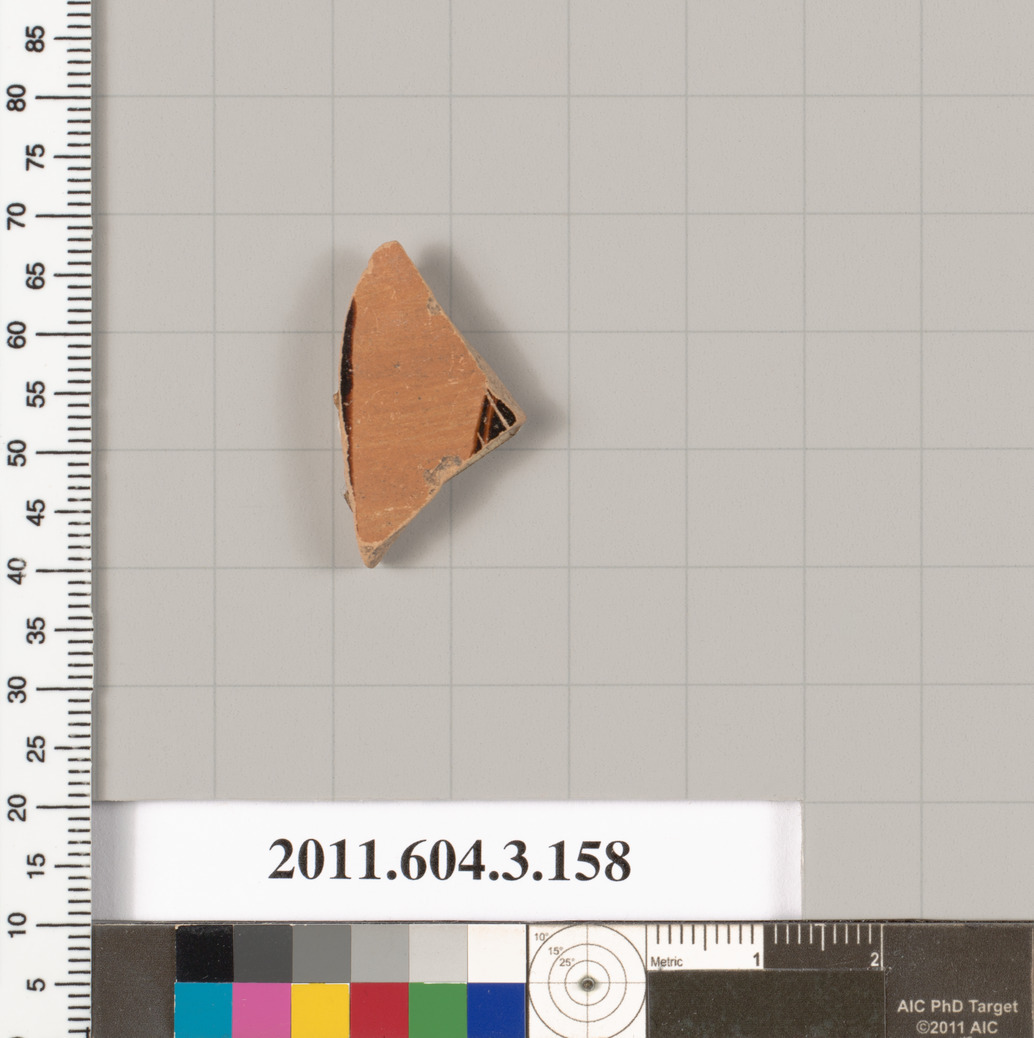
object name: amphora fragment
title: Terracotta fragment of an amphora (jar)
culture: greek, attic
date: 550-540 BCE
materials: terracotta